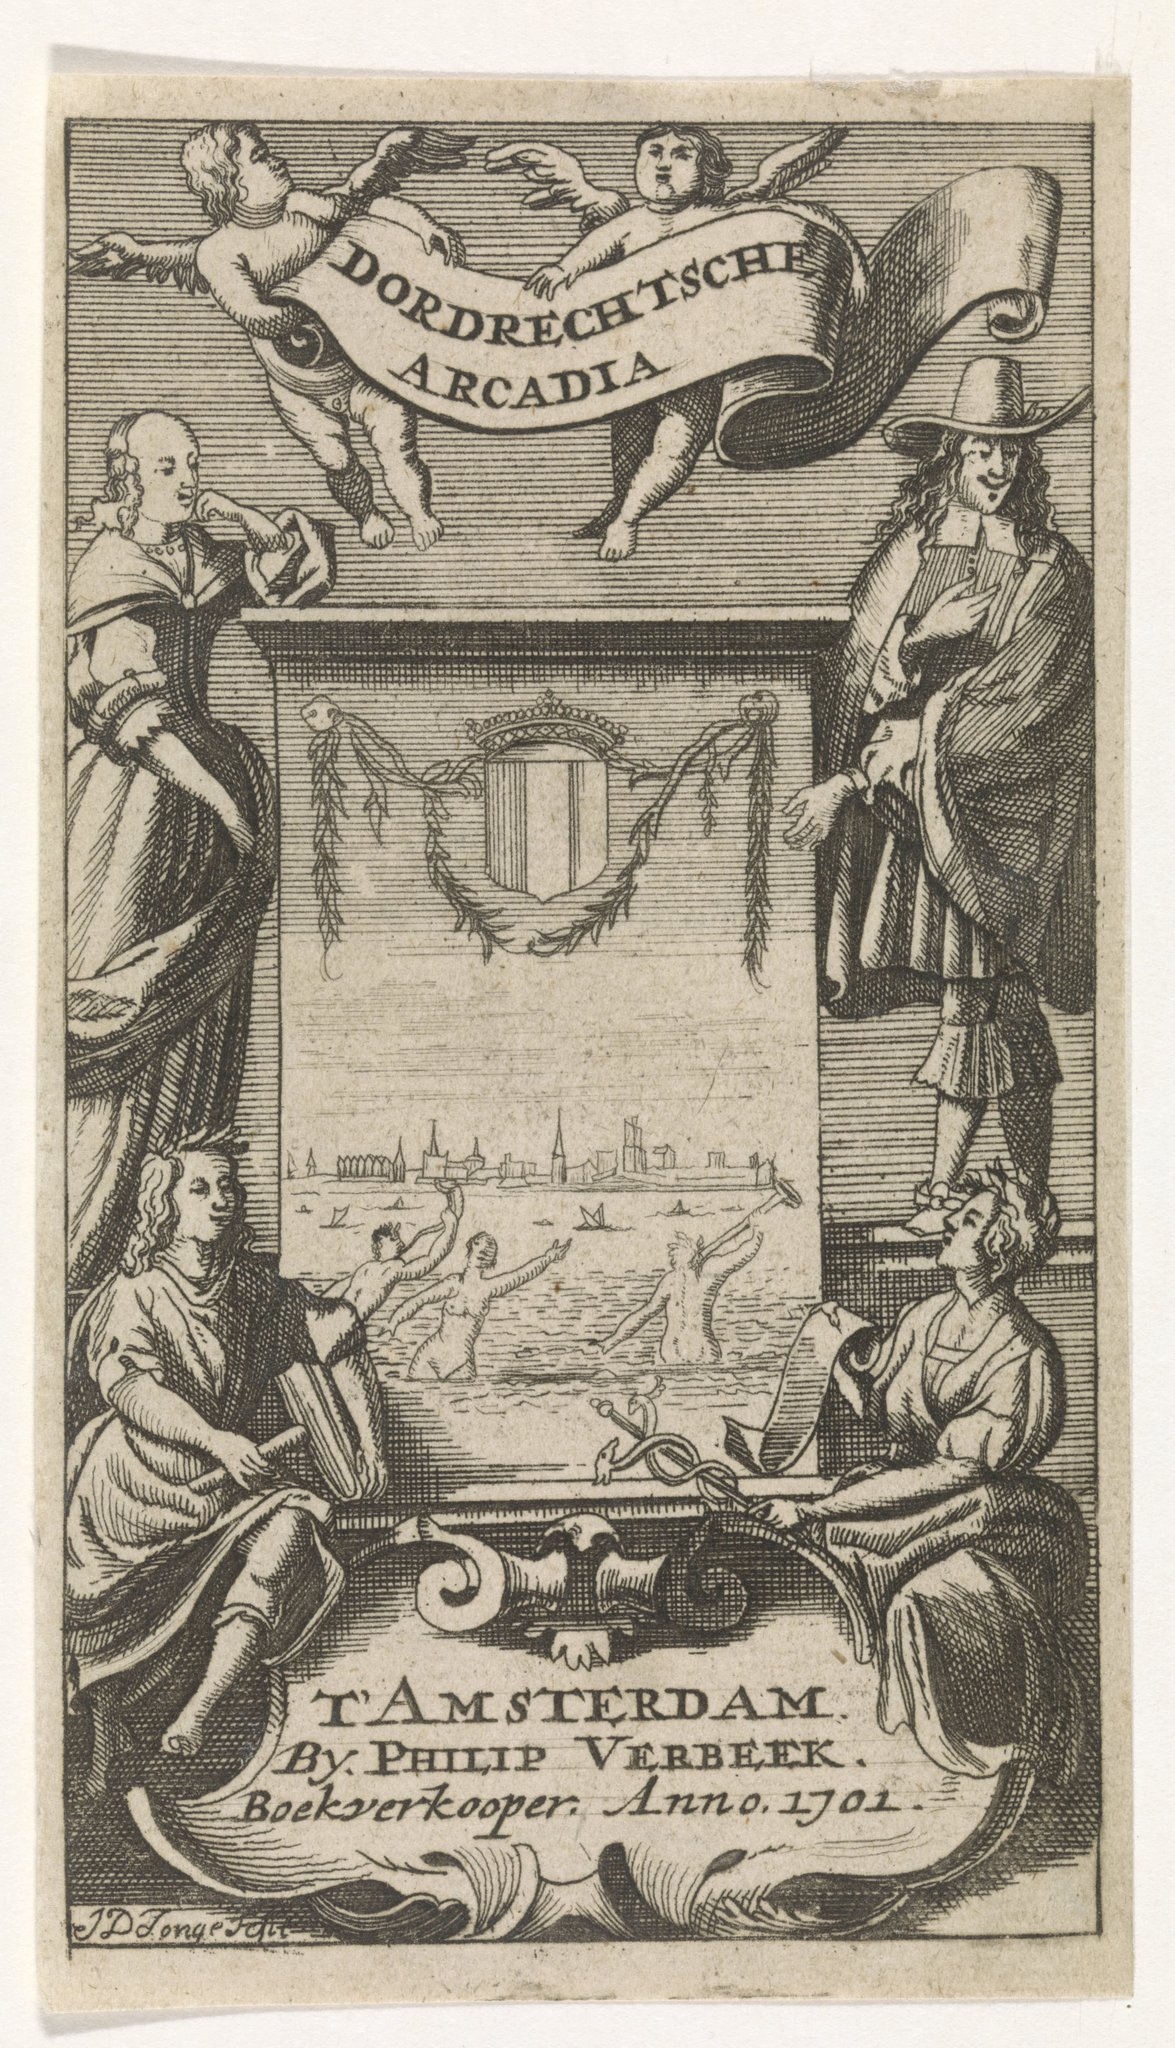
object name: print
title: Vier figuren rondom kader met gezicht op Dordrecht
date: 1701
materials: paper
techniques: etching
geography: middelburg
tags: dordrecht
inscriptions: collector's mark: Lugt 2228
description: Vier figuren rondom een kader waarop een wapenschild, een gezicht op de stad Dordrecht en figuren in het water. Daarboven twee engelen met banderol waarin de titel. In een cartouche de naam van de boekverkoper.